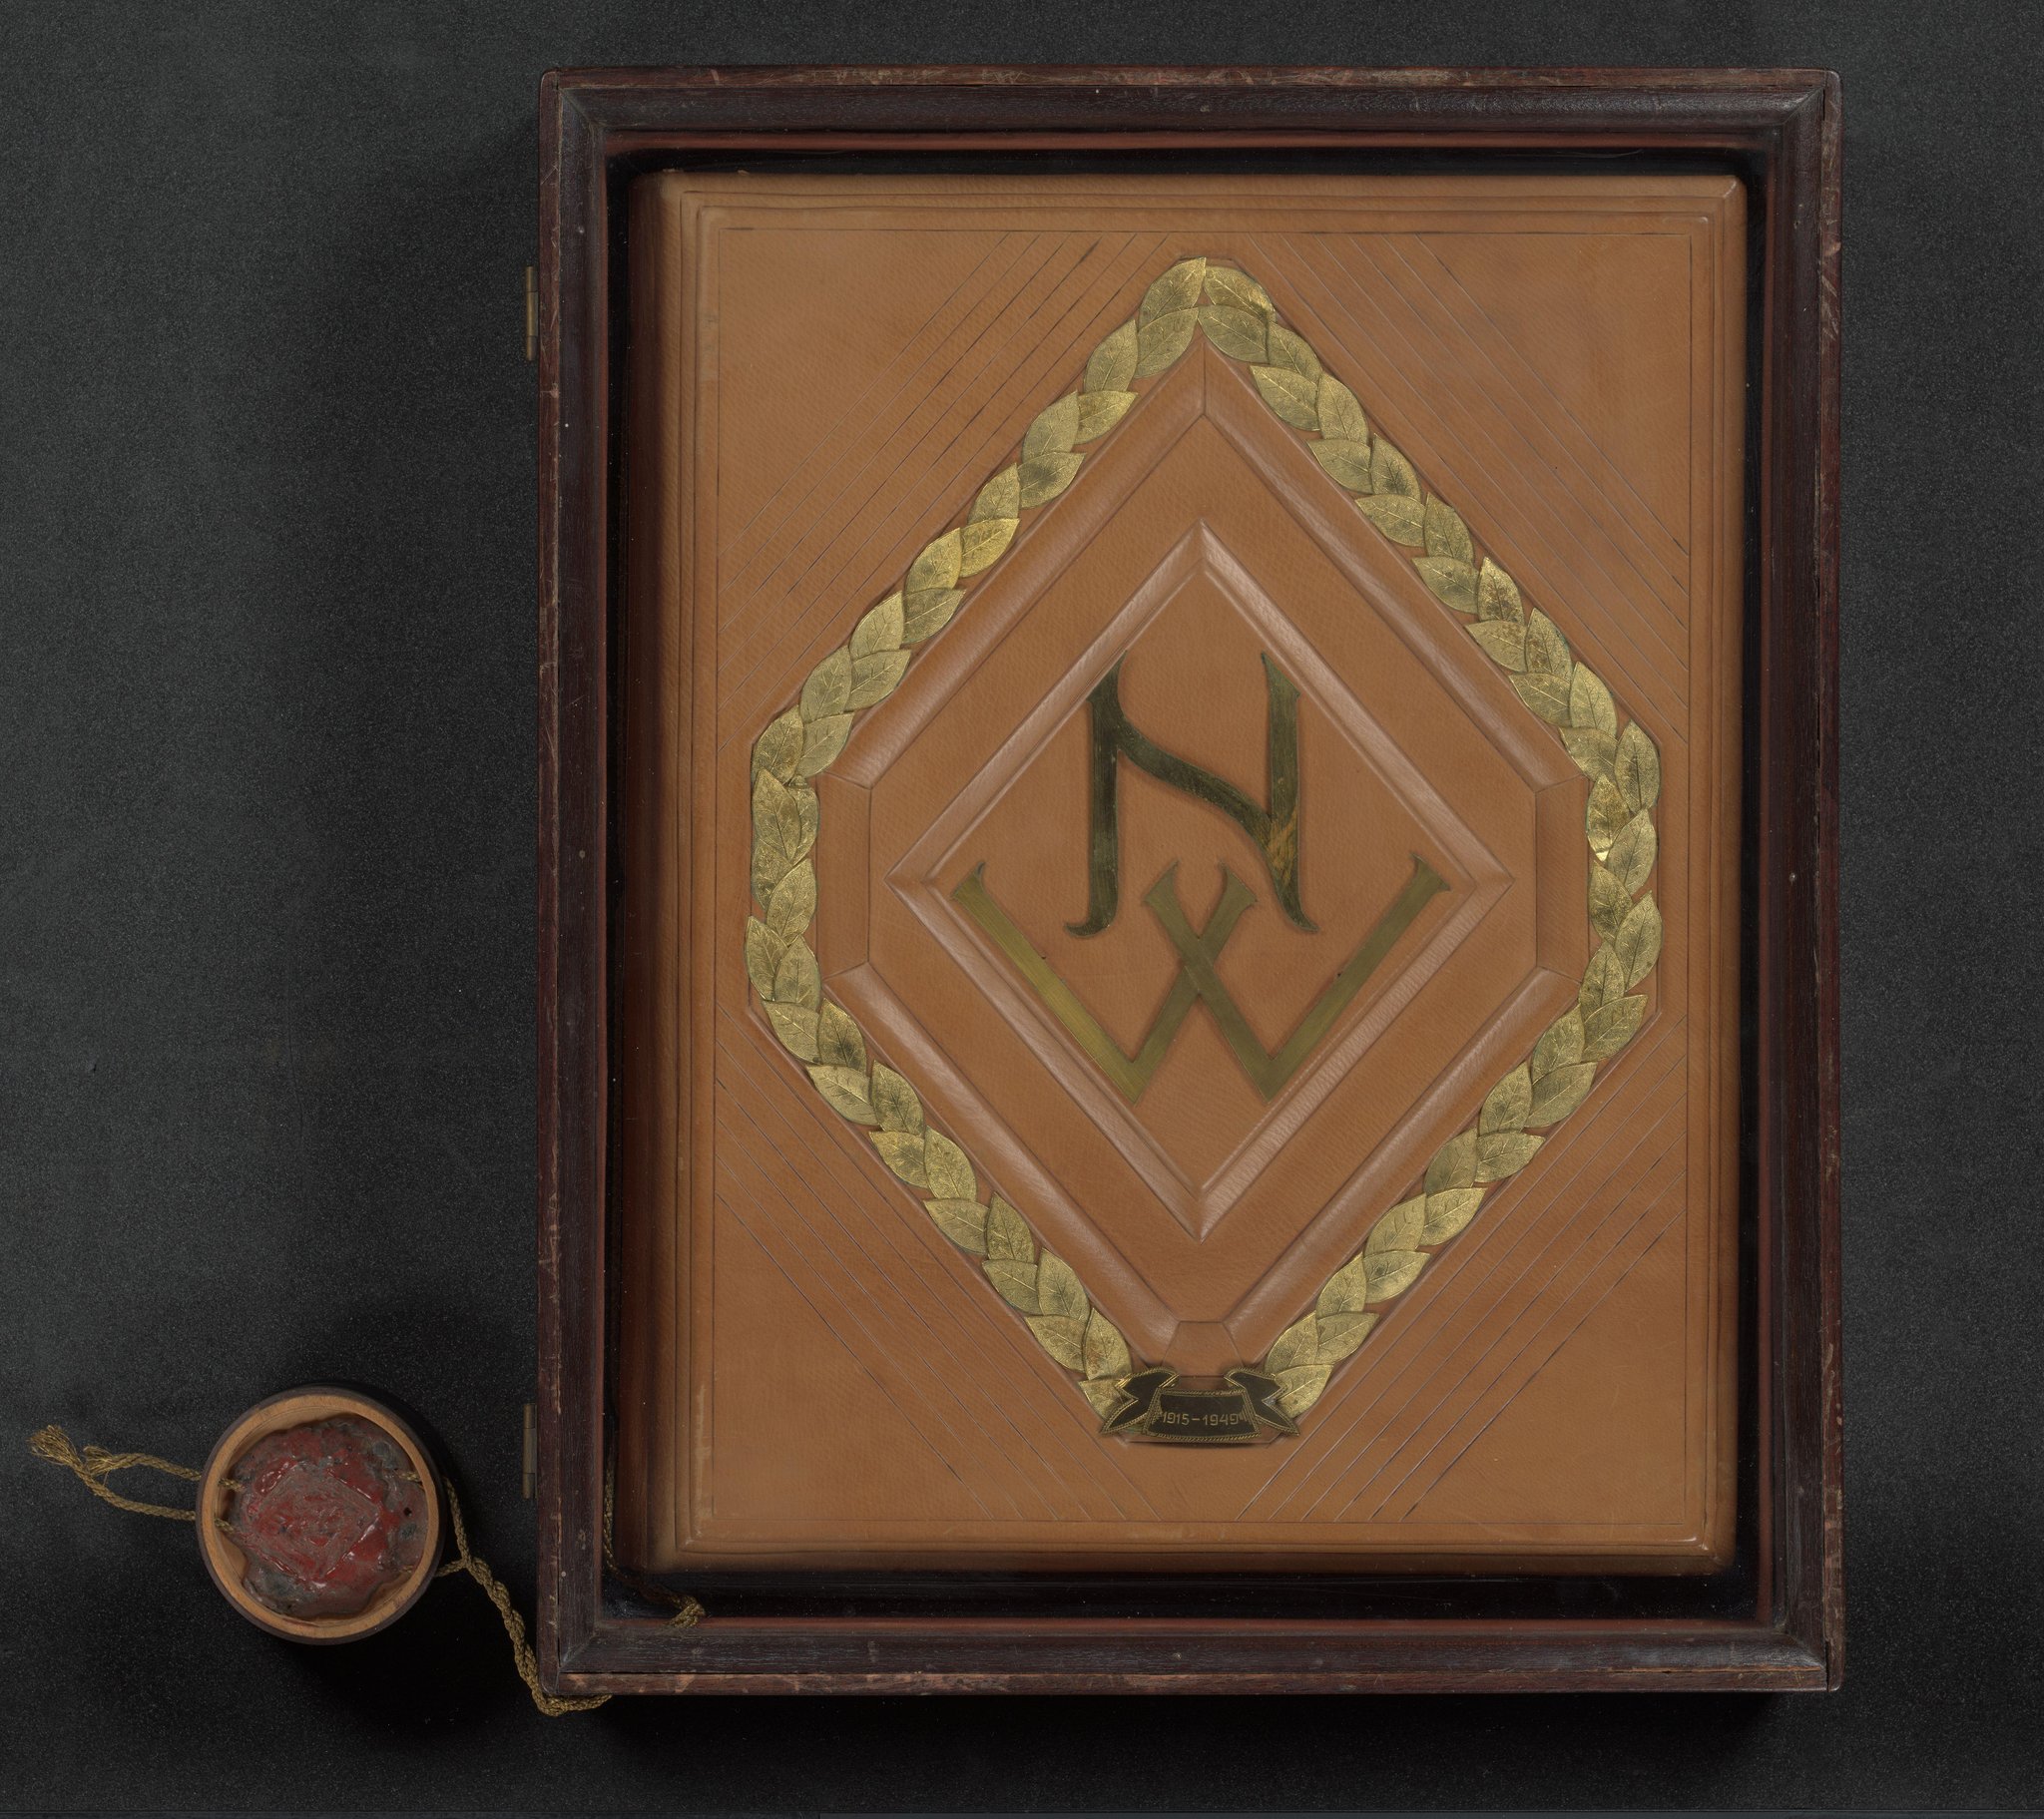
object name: lakzegel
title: Houten doosje met lakzegel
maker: Anonymous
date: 1949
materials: wax, wood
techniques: printing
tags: modern professional organization, trade union, reception, cocktail party, seal, stamp, amsterdam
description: Rond houten doosje met afhangend lakzegel met het monogram van de NVV (onduidelijk). Onderdeel van het fotoalbum ter gelegenheid van het afscheid van Evert Kupers als voorzitter van de NVV op 14 juli 1949 in Amsterdam.